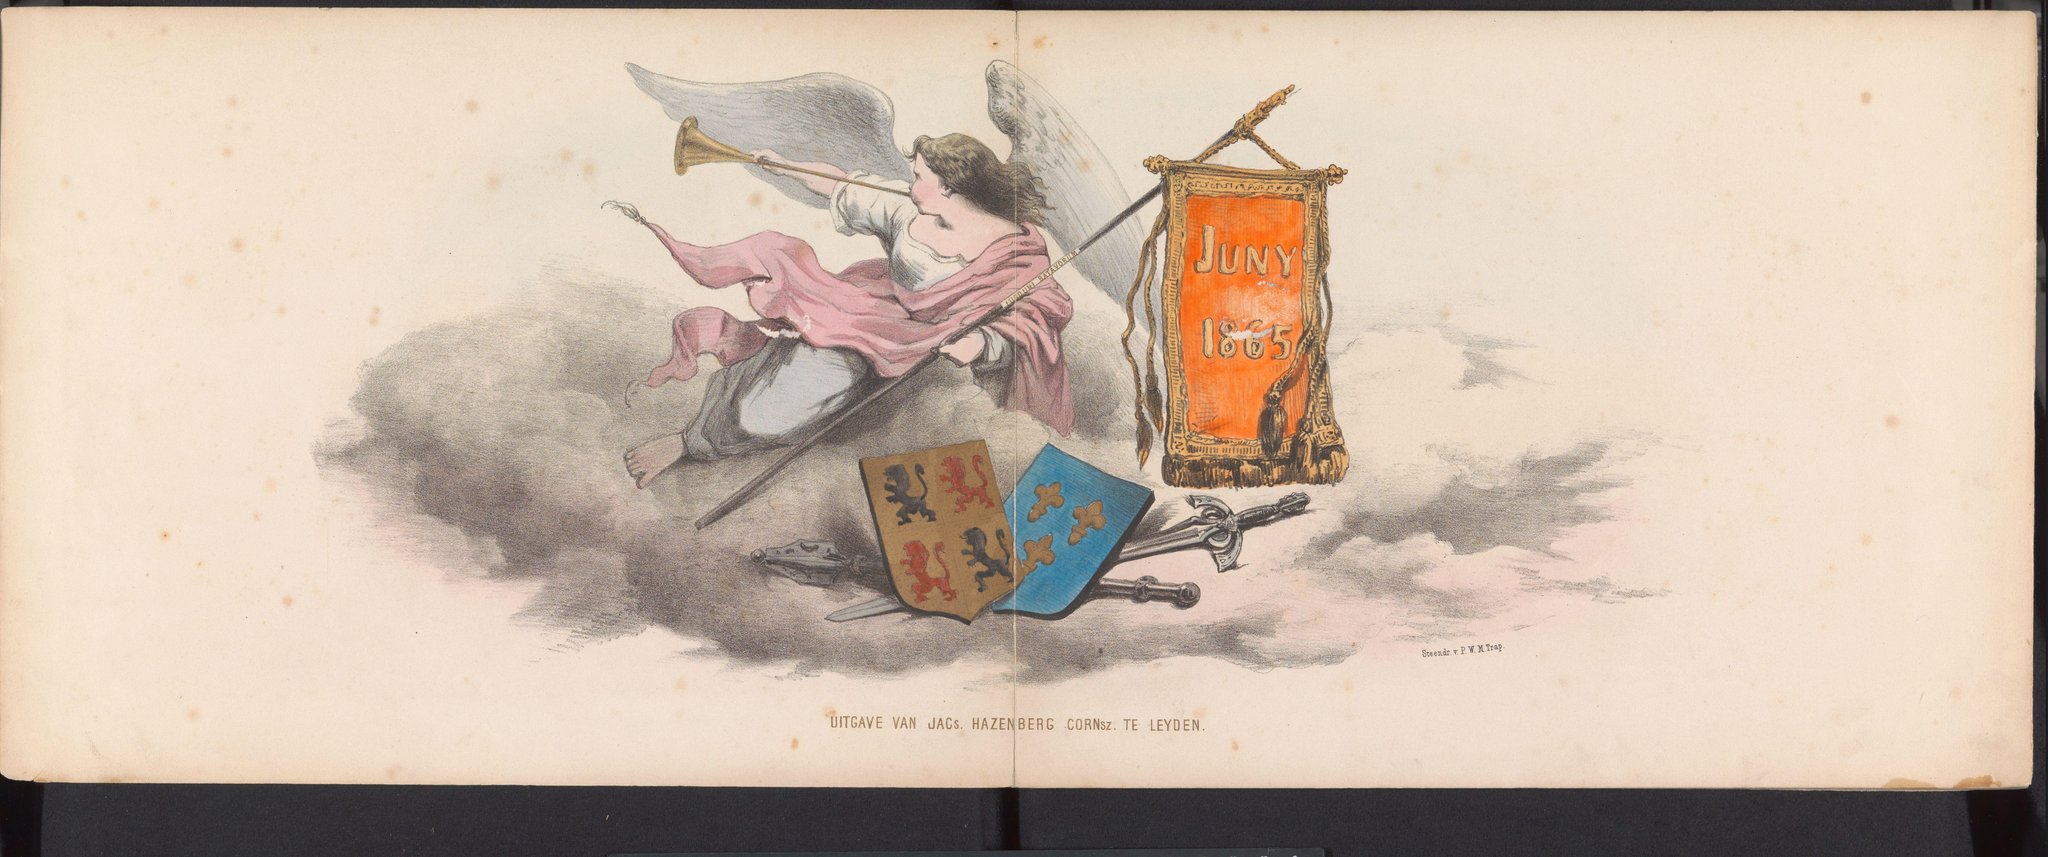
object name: print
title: Gecostumeerde optogt gehouden door de leden van het Leidsche studenten-corps den 6den Junij 1865, ter viering van den 290sten verjaardag der Leidsche Hoogeschool, voorstellende: de intogt der Hollanders binnen Zierikzee onder Jonker Willem, Grave van Oostervant, op den 12den augustus Anno 1304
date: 1865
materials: paper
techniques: hand coloring, lithograph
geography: netherlands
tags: fame; 'fama', 'fama buona', 'fama chiara' (ripa), leiden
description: Historische gekostumeerde optocht van de studenten van de Leidse Hogeschool gehouden op 6 juni 1865 ter gelegenheid van het 290-jarig bestaan van de Hogeschool. De optocht verbeeldt de intocht van de Hollanders binnen Zierikzee op 12 augustus 1304. De Faam met een vaandel. Titelprent, onderdeel van de serie van 16 aaneen geplakte bladen.